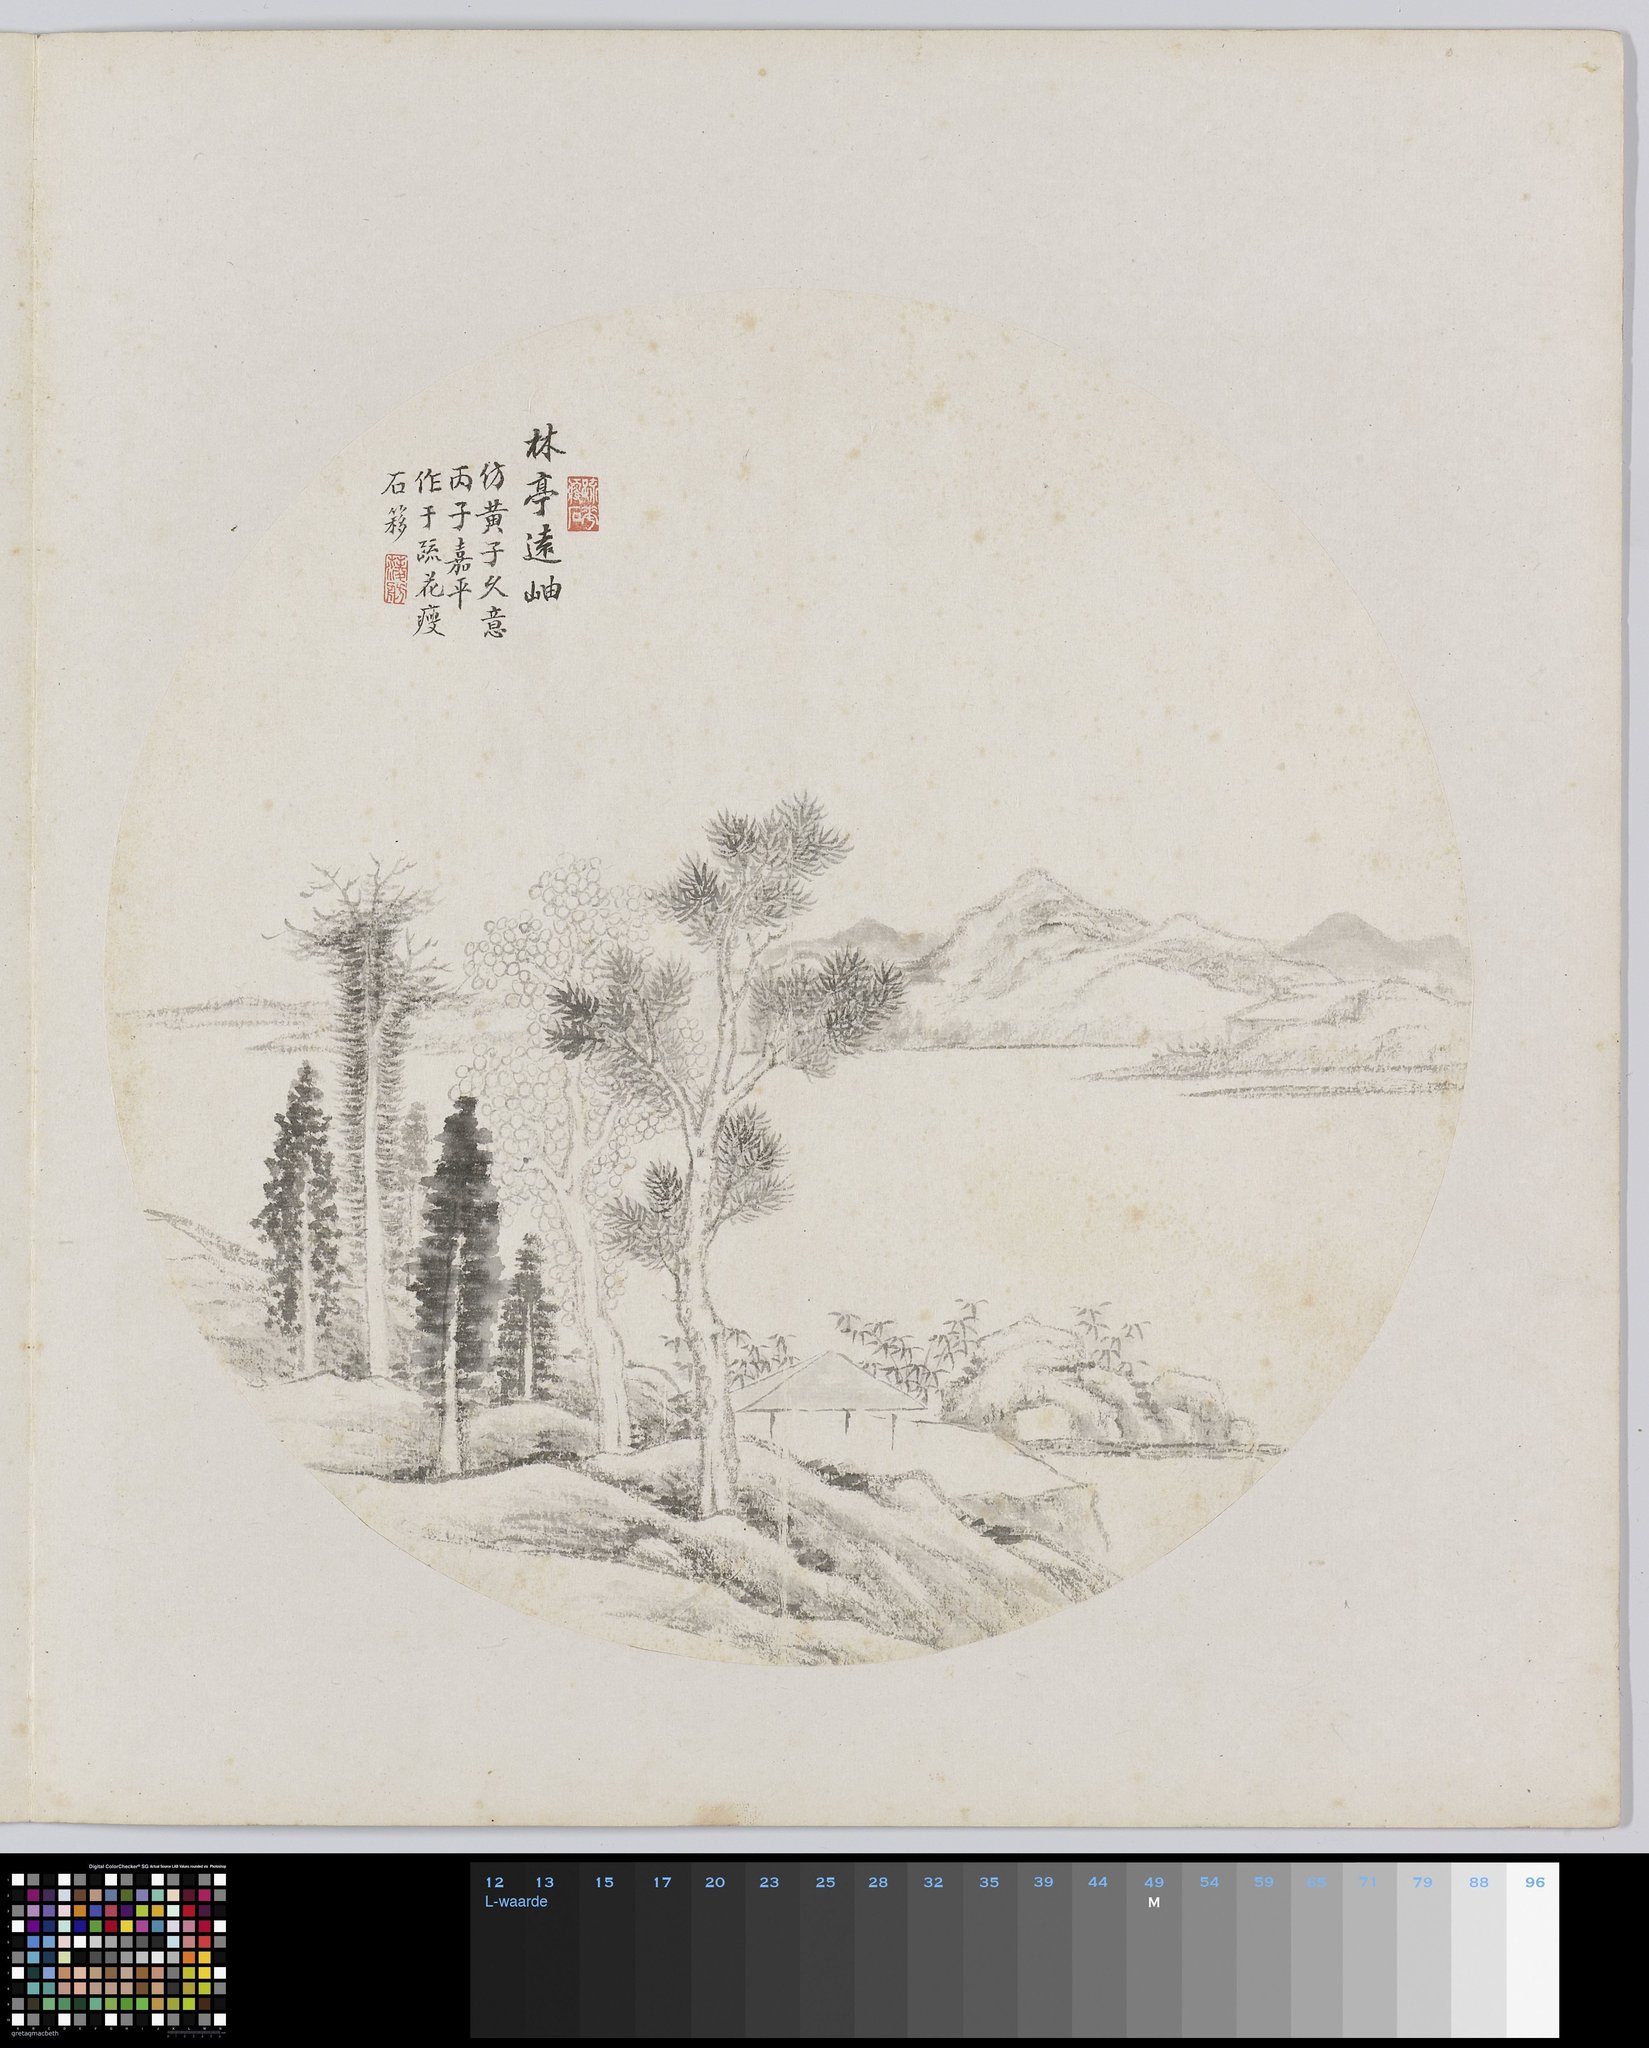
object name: painting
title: Albumblad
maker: hui nian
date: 1850-1900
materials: ink, paper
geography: china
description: Albumblad met een landschap. Behoort twee albums met 24 landschappen in de stijl van diverse meesters.